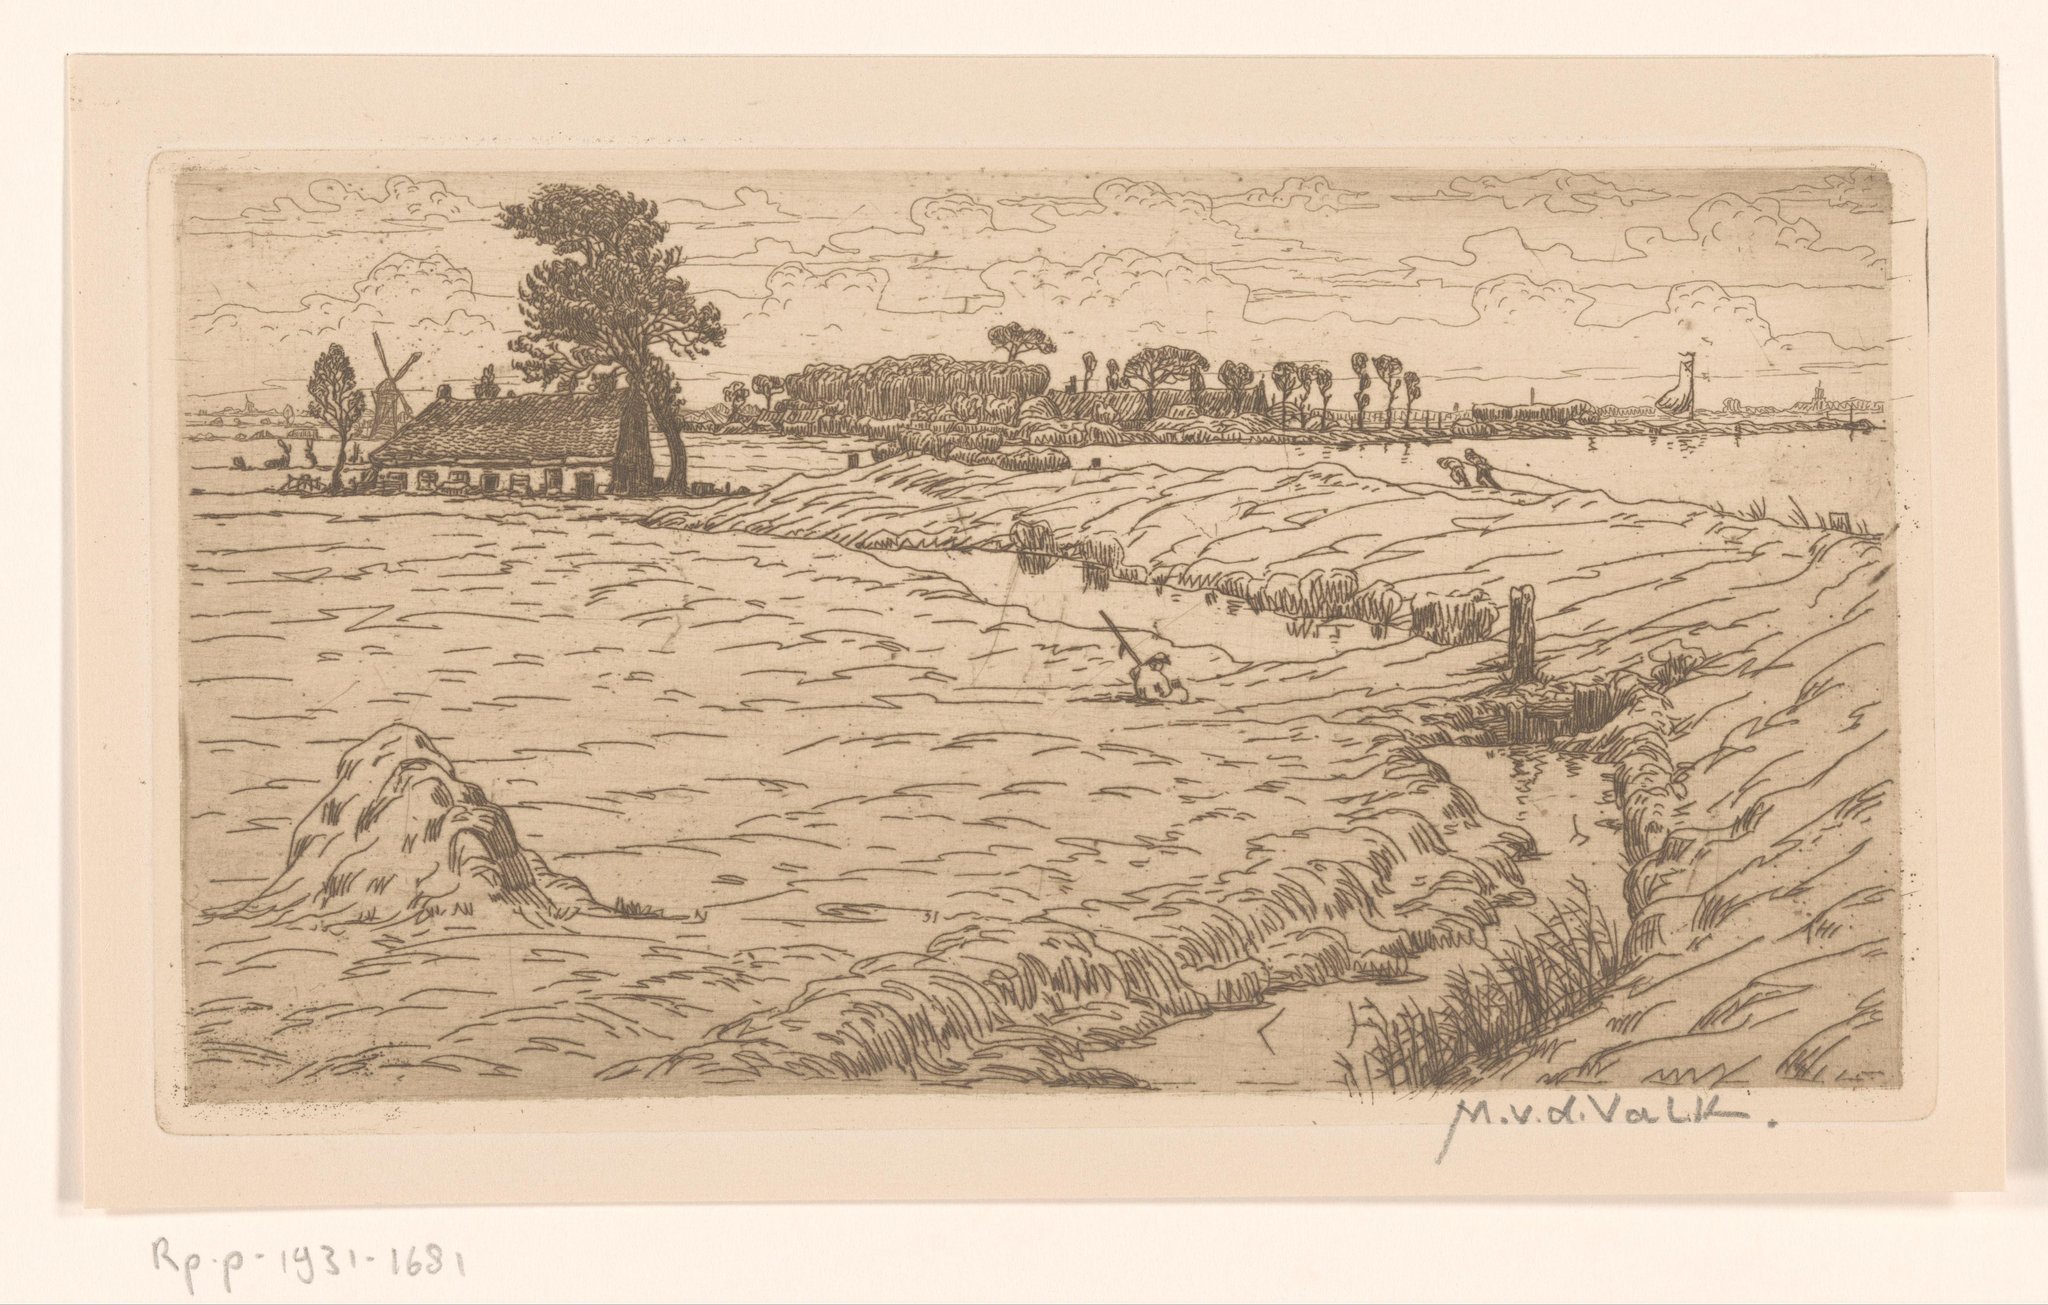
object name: print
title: Landschap met weiland, boerderij en water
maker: maurits van der valk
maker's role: draughtsman, print maker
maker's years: 1857-1935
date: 1867-1931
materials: paper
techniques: drypoint, etching, intaglio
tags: meadow, pasture, farm or solitary house in landscape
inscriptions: collector's mark: Lugt 2228